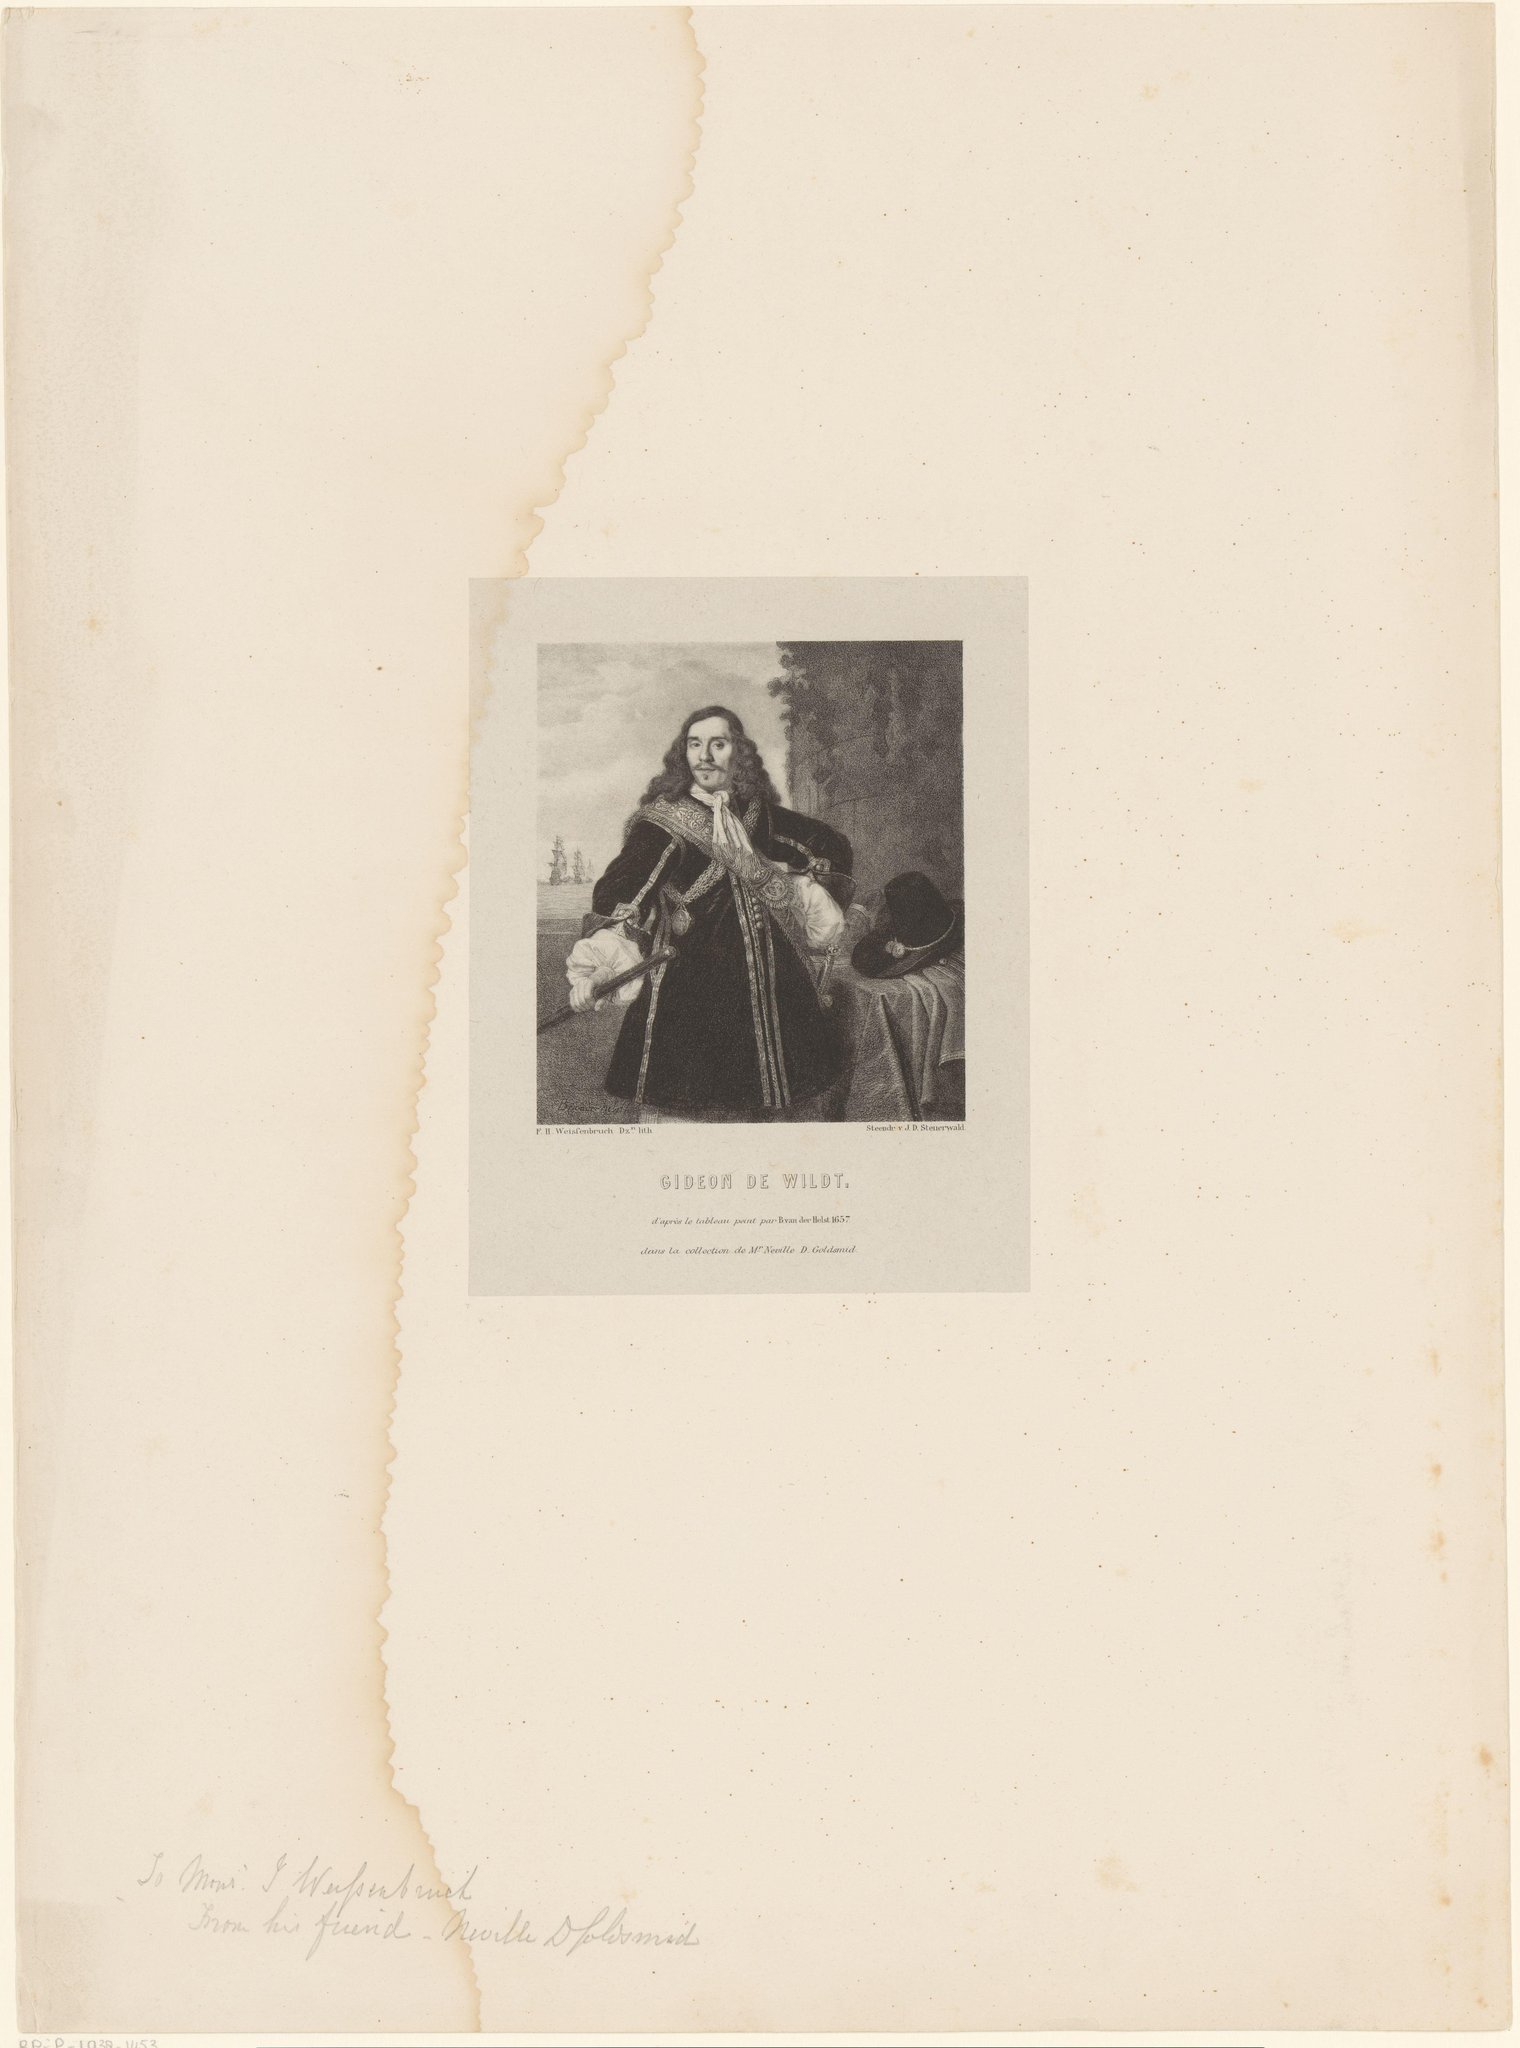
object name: print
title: Gideon de Wildt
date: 1866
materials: paper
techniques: lithograph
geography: the hague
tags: historical persons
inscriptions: collector's mark: Lugt 2228, inscription: ‘To Mons. J. Weissenbruch / From his friend Neville D. Goldsmid’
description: Prent uit Kunstkronijk, 1866 en De Nederlandsche Spectator, 1866. Naar Kapitein Gideon de Wildt (1657) van Bartholomeus van der Helst in het Szépmüvészeti Múzeum te Boedapest.